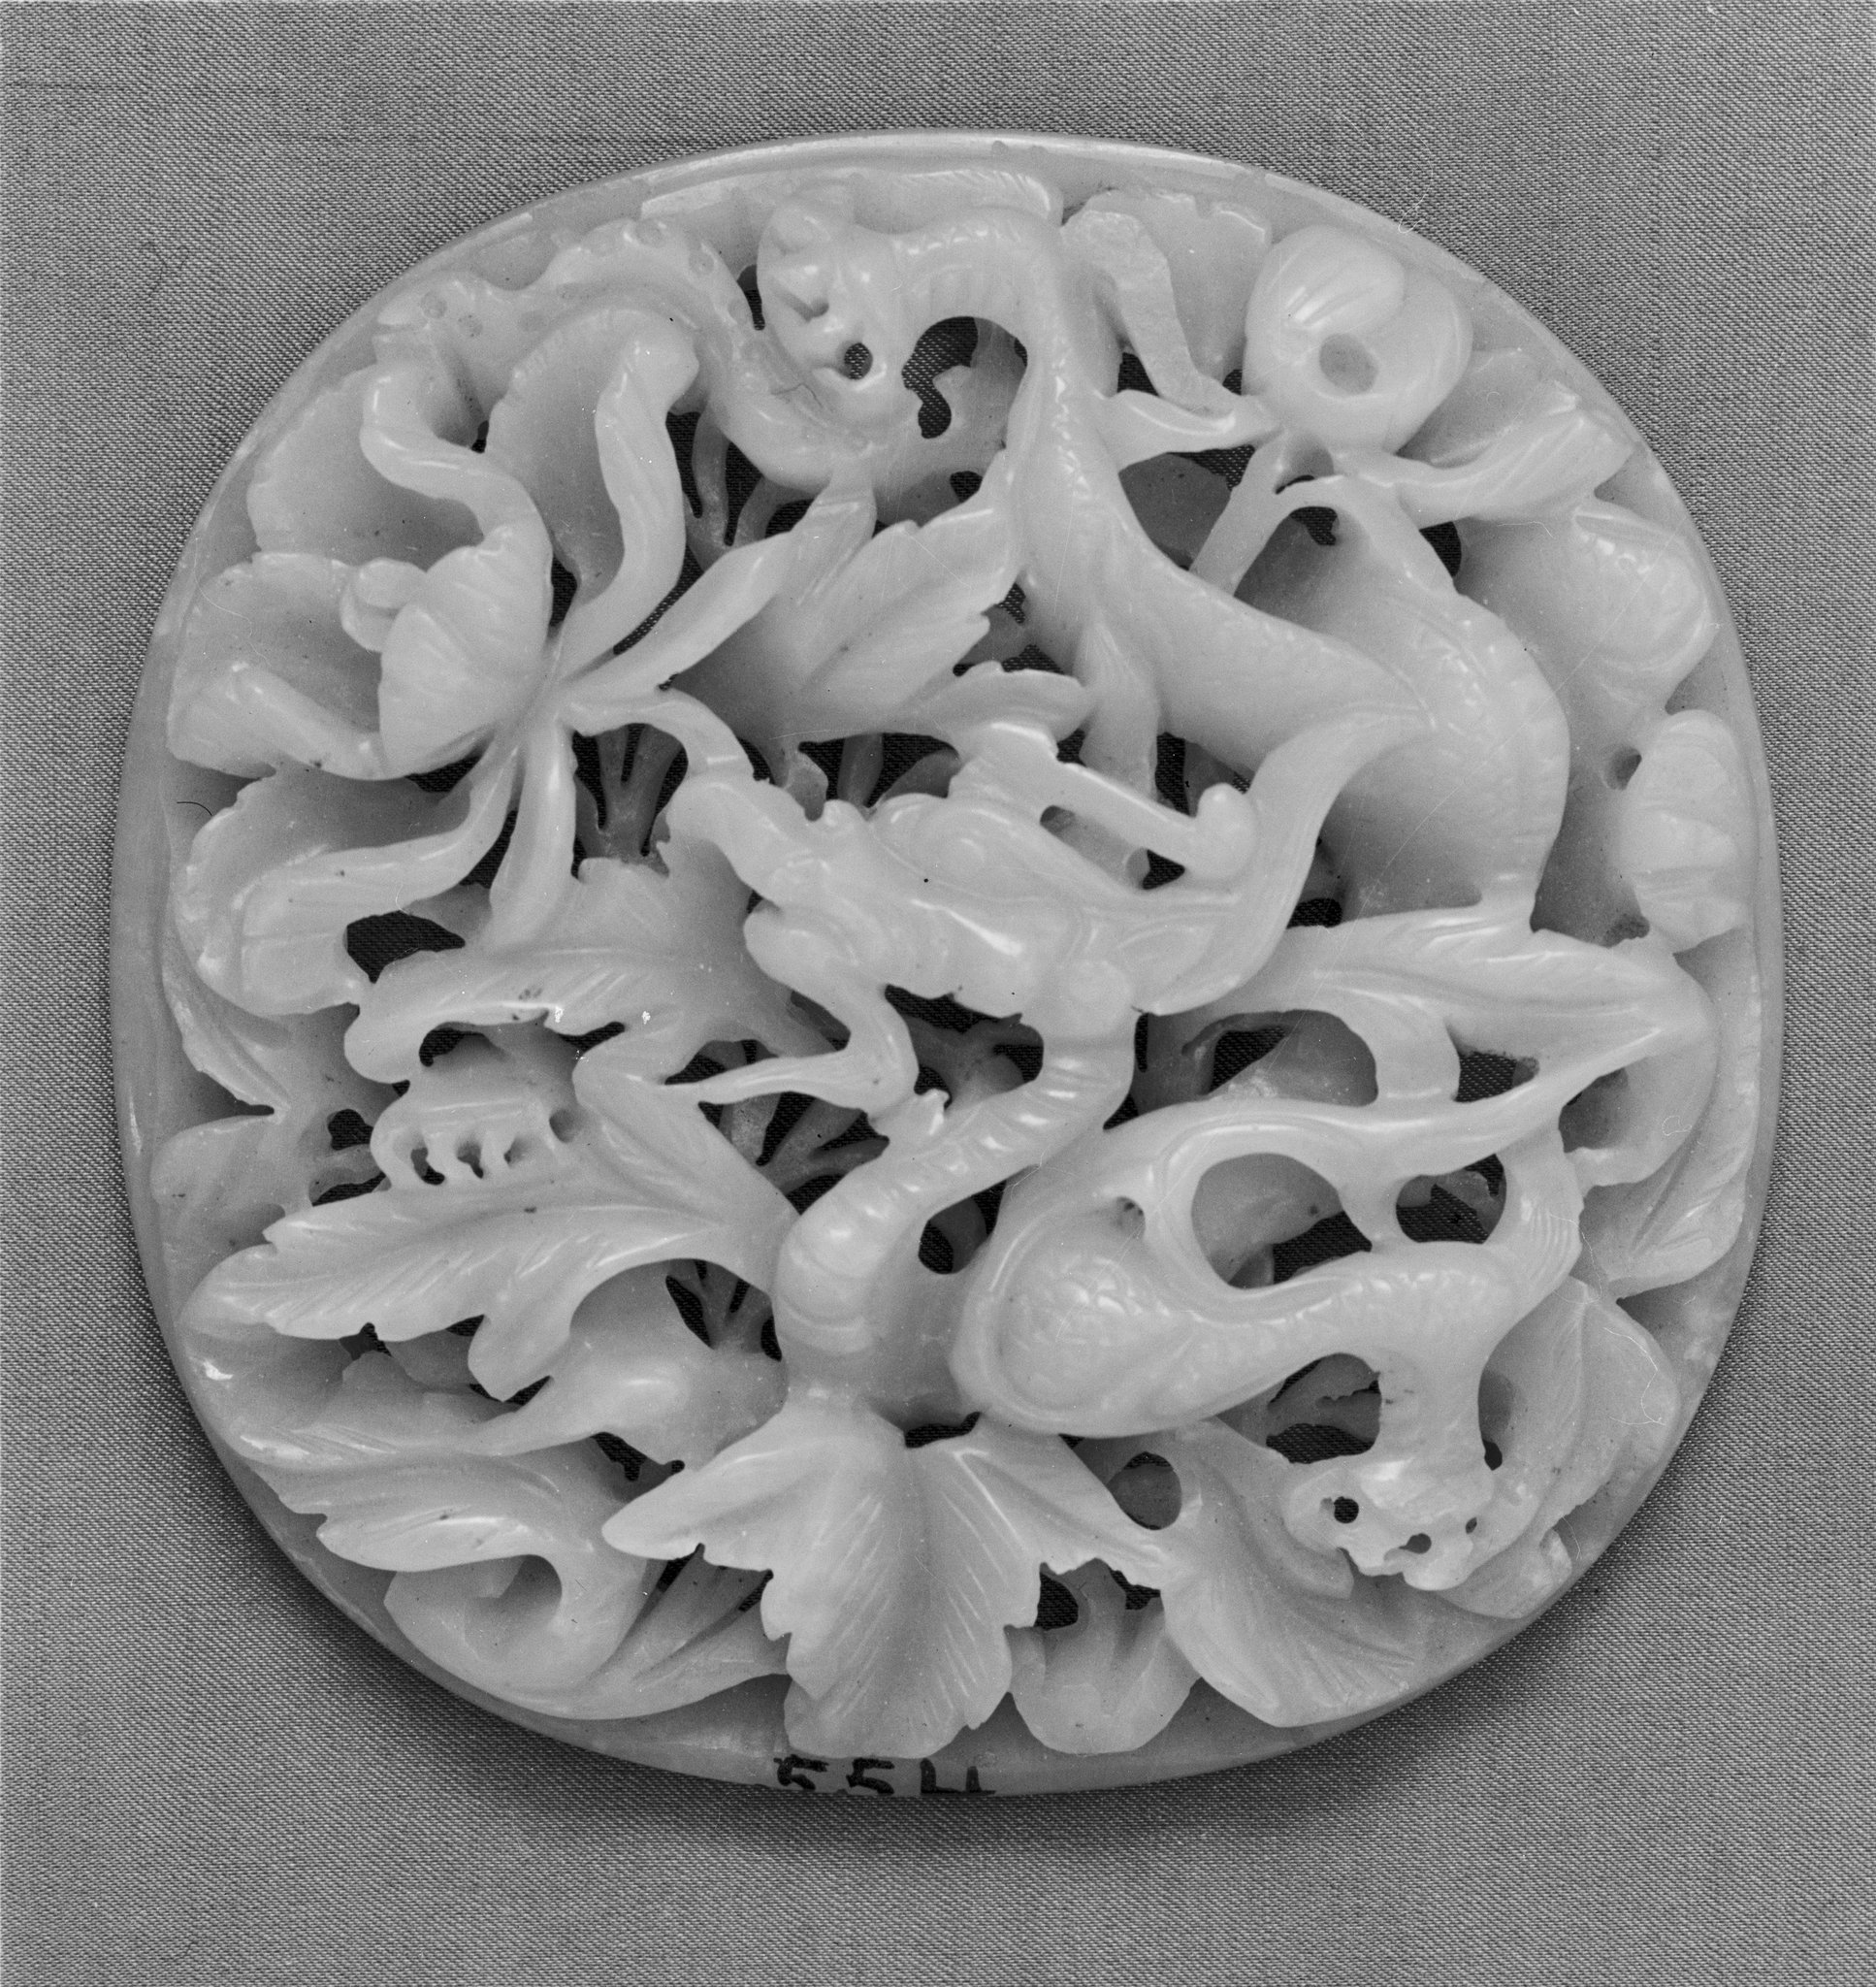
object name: belt plaque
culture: chinese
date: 1401-1600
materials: jade